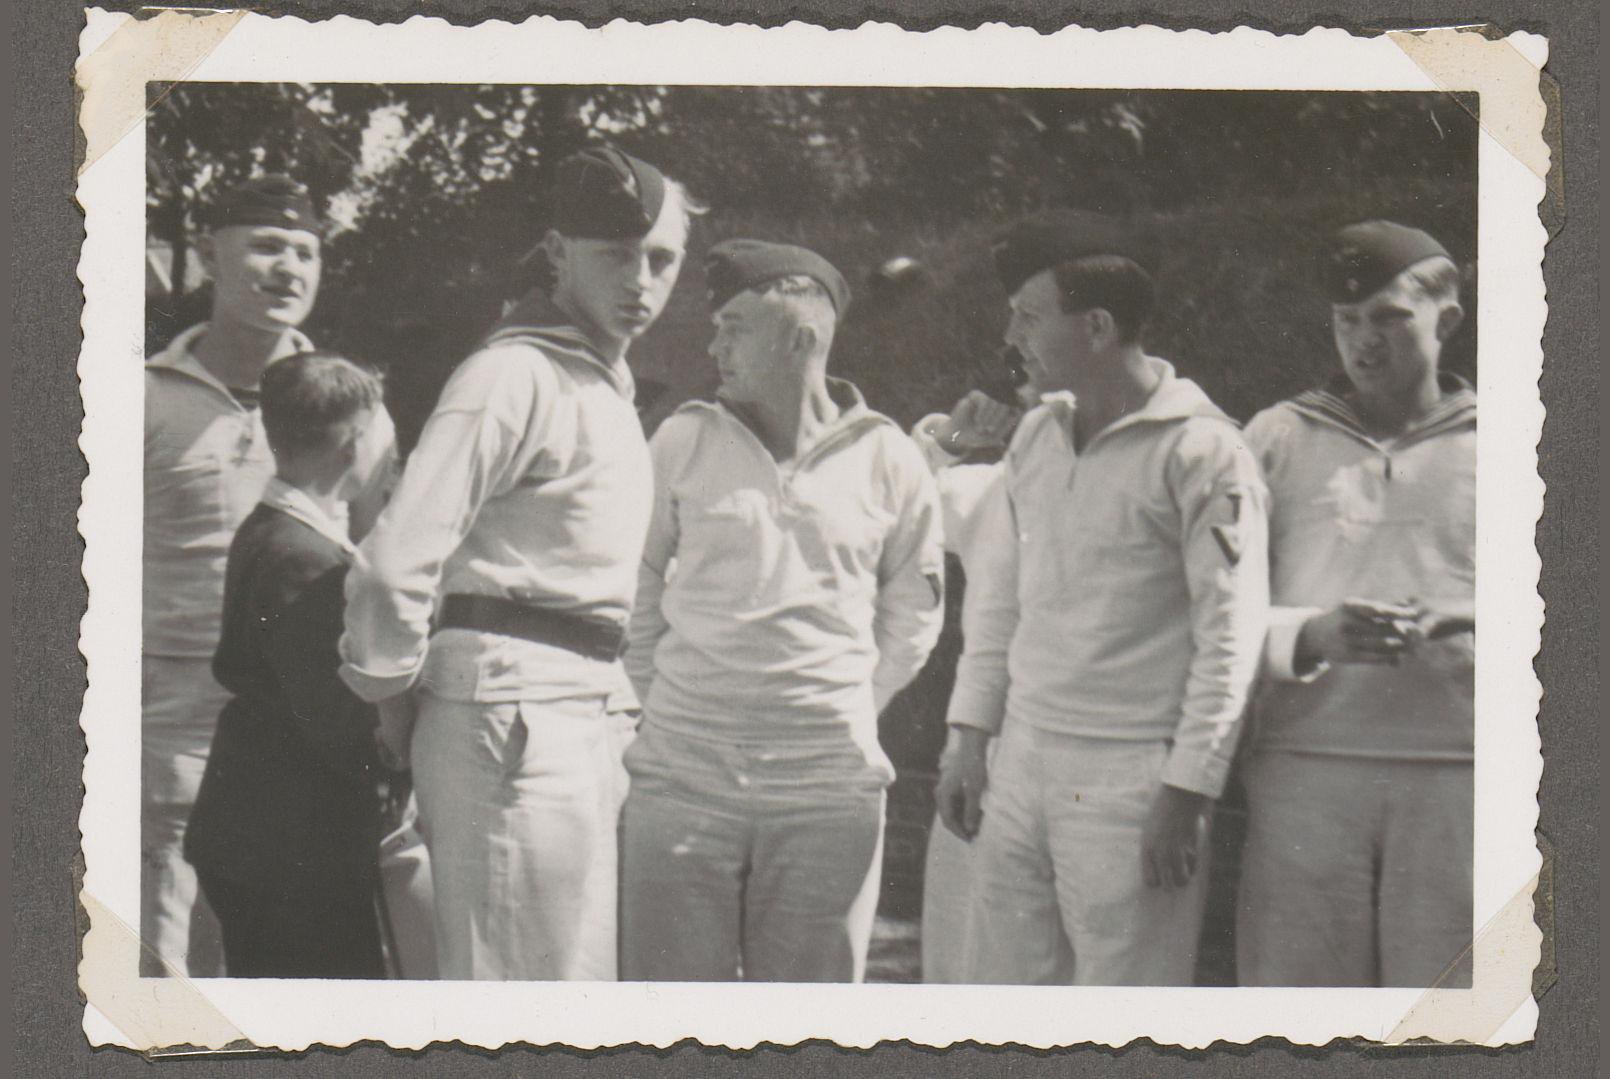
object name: photograph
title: Militairen in afwachting van keuring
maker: Anonymous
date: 1941-1945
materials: paper, photographic support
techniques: gelatin silver print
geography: netherlands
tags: the soldier; the soldier's life, occupation ~ war, netherlands